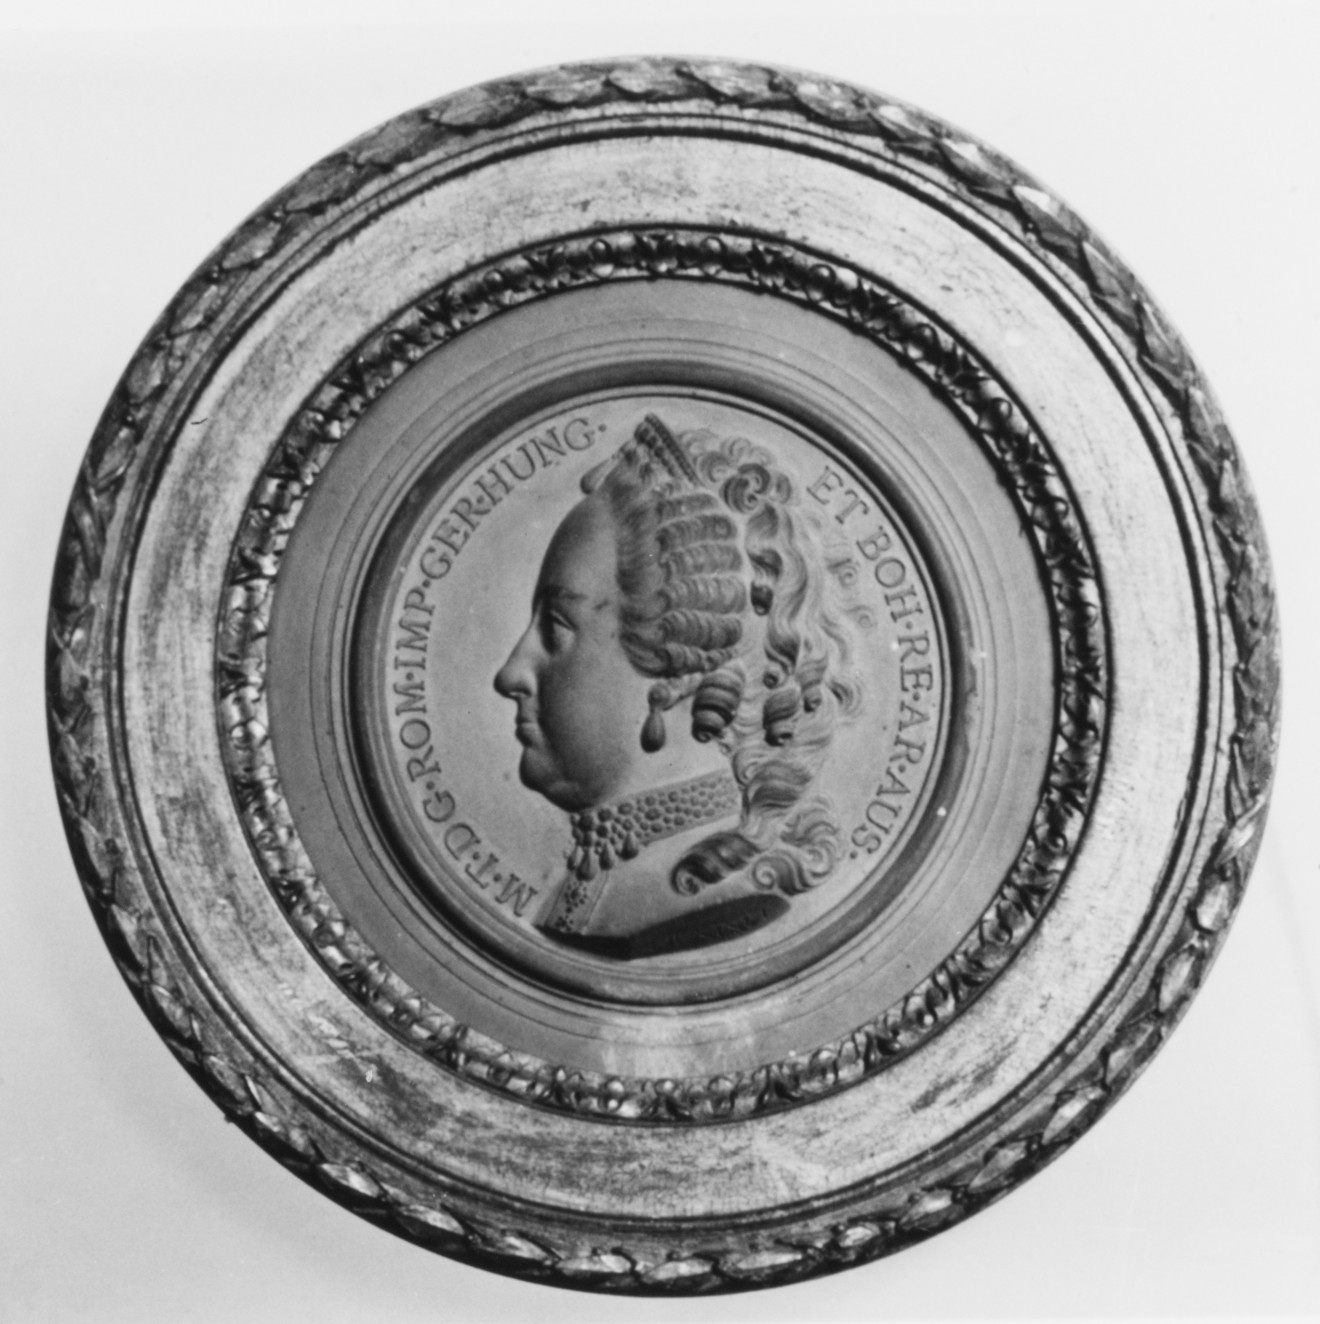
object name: medallion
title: Empress Maria Theresa (1717–1780)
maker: jean-baptiste nini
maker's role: artist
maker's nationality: italian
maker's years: 1717-1786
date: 1769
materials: gilt, terracotta, wood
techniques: casting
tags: profiles,women